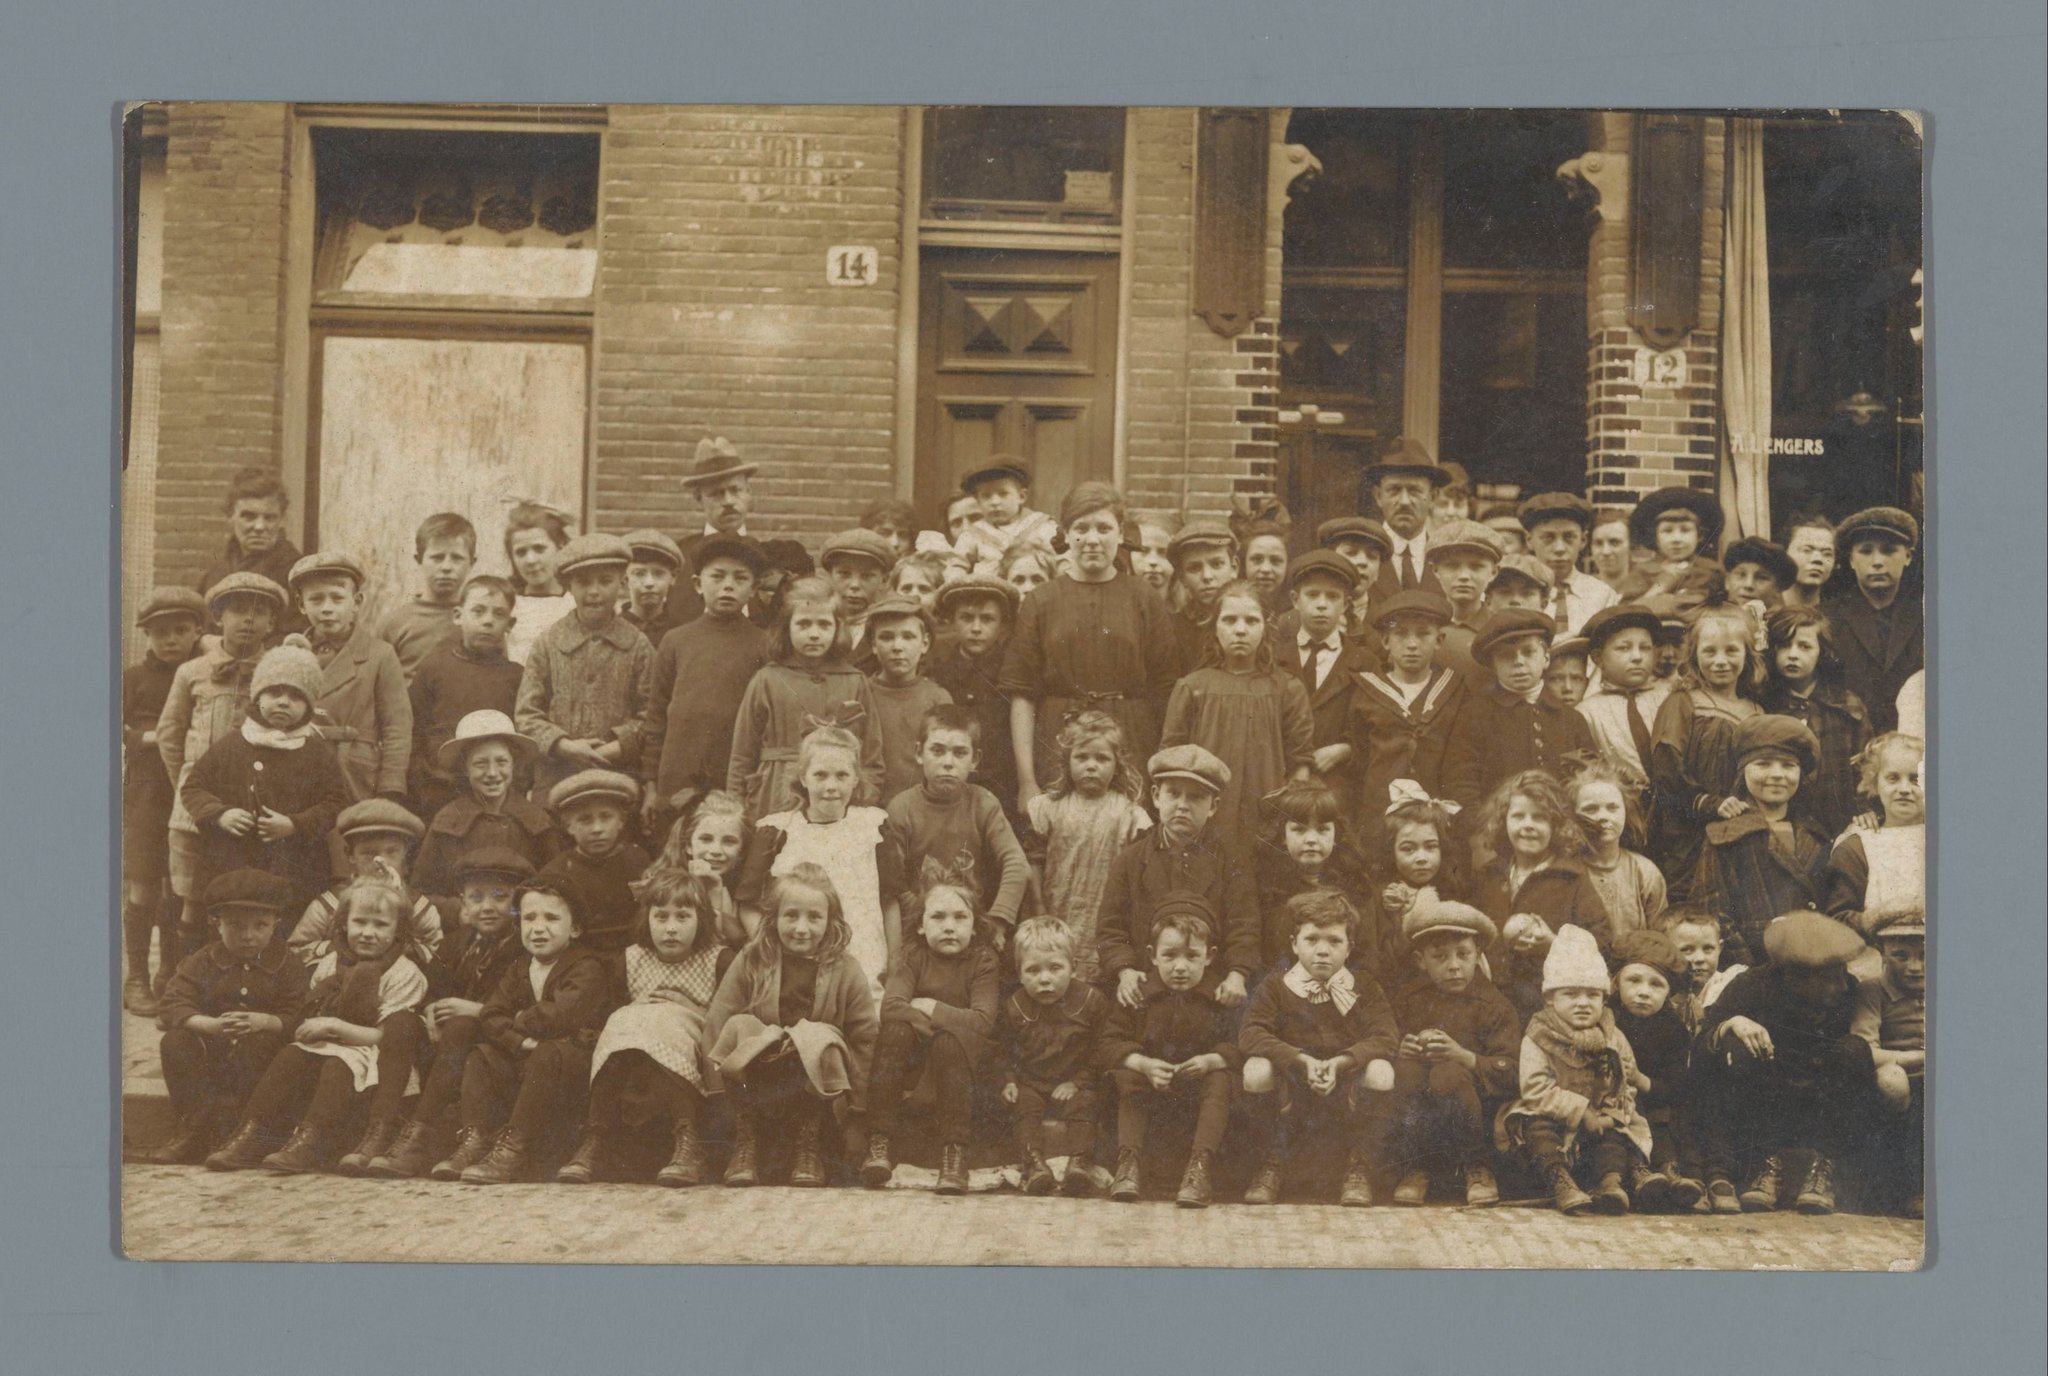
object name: photograph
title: Groepsportret van kinderen en (vermoedelijk) leerkrachten in een straat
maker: Anonymous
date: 1910-1915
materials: photographic support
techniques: gelatin silver print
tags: child, façade (of house or building), anonymous historical persons portrayed in a group, in a group-portrait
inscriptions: date: ‘1915’